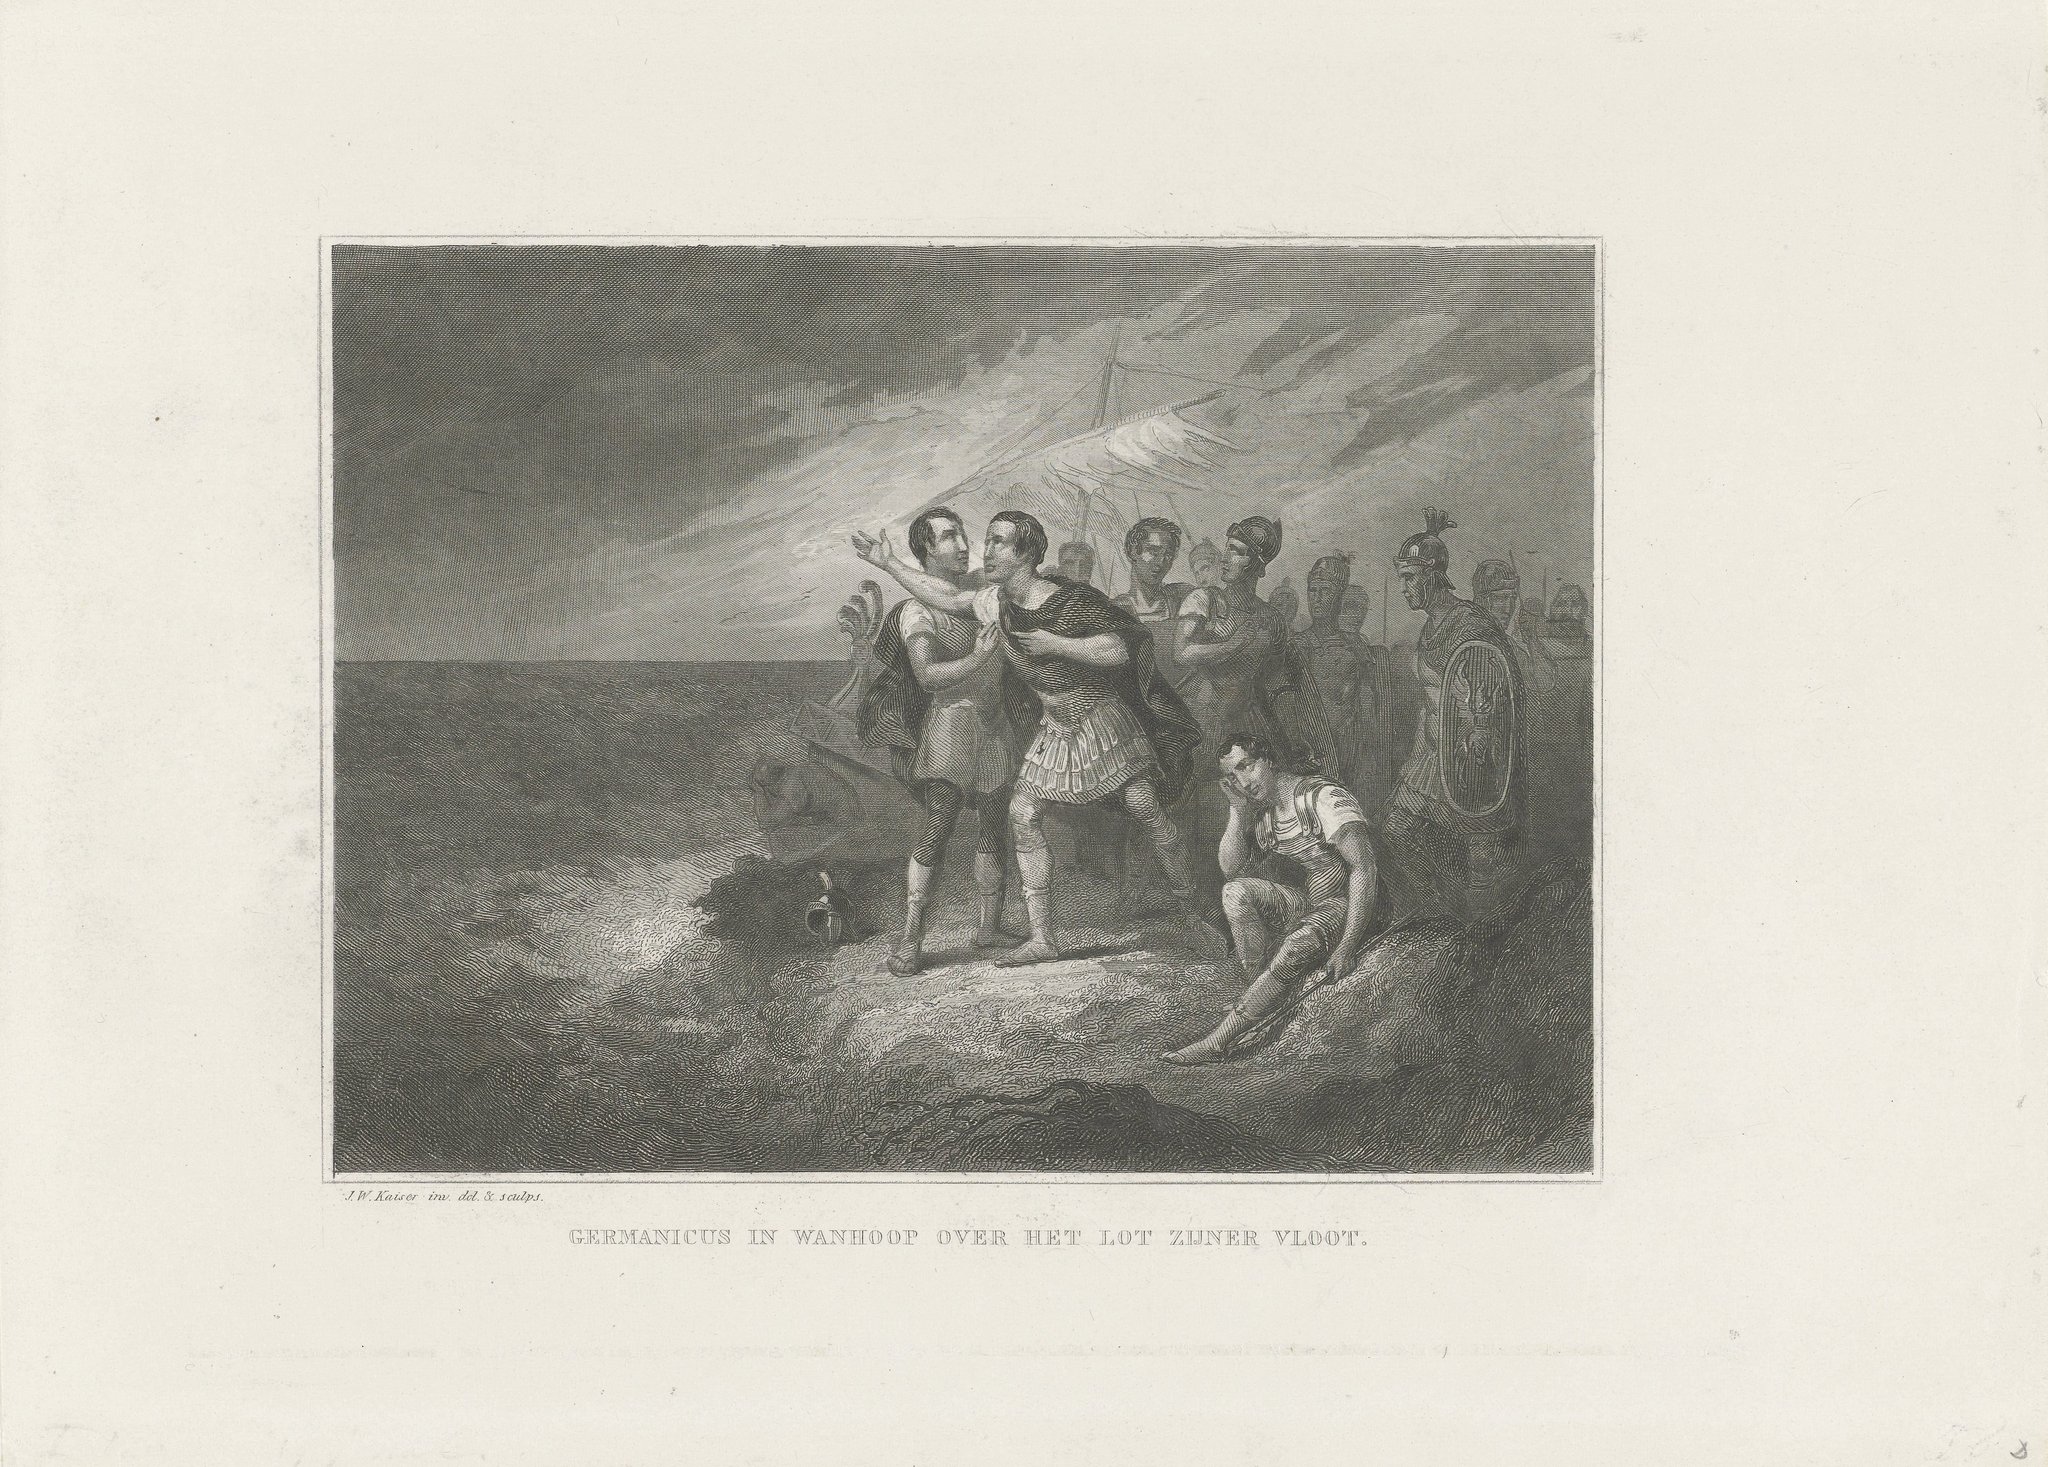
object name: book illustration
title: Romeinse veldheer Germanicus treurt over het verlies van zijn vloot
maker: johann wilhelm kaiser (i)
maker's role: draughtsman, print maker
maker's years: 1813-1900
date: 1840-1884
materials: paper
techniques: engraving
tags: male persons from classical history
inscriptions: collector's mark: Lugt 2228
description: De Romeinse veldheer Germanicus staat samen met zijn soldaten aan de kust van Chauken (tussen de Eems en de Elbe) en heeft zijn rechterhand en zijn hoofd opgeheven richting de hemel. Hij betreurt het lot van zijn verongelukte vloot. Op de achtergrond is de mast van een gehavend zeilschip te zien. Gebeurtenis uit het jaar 17.